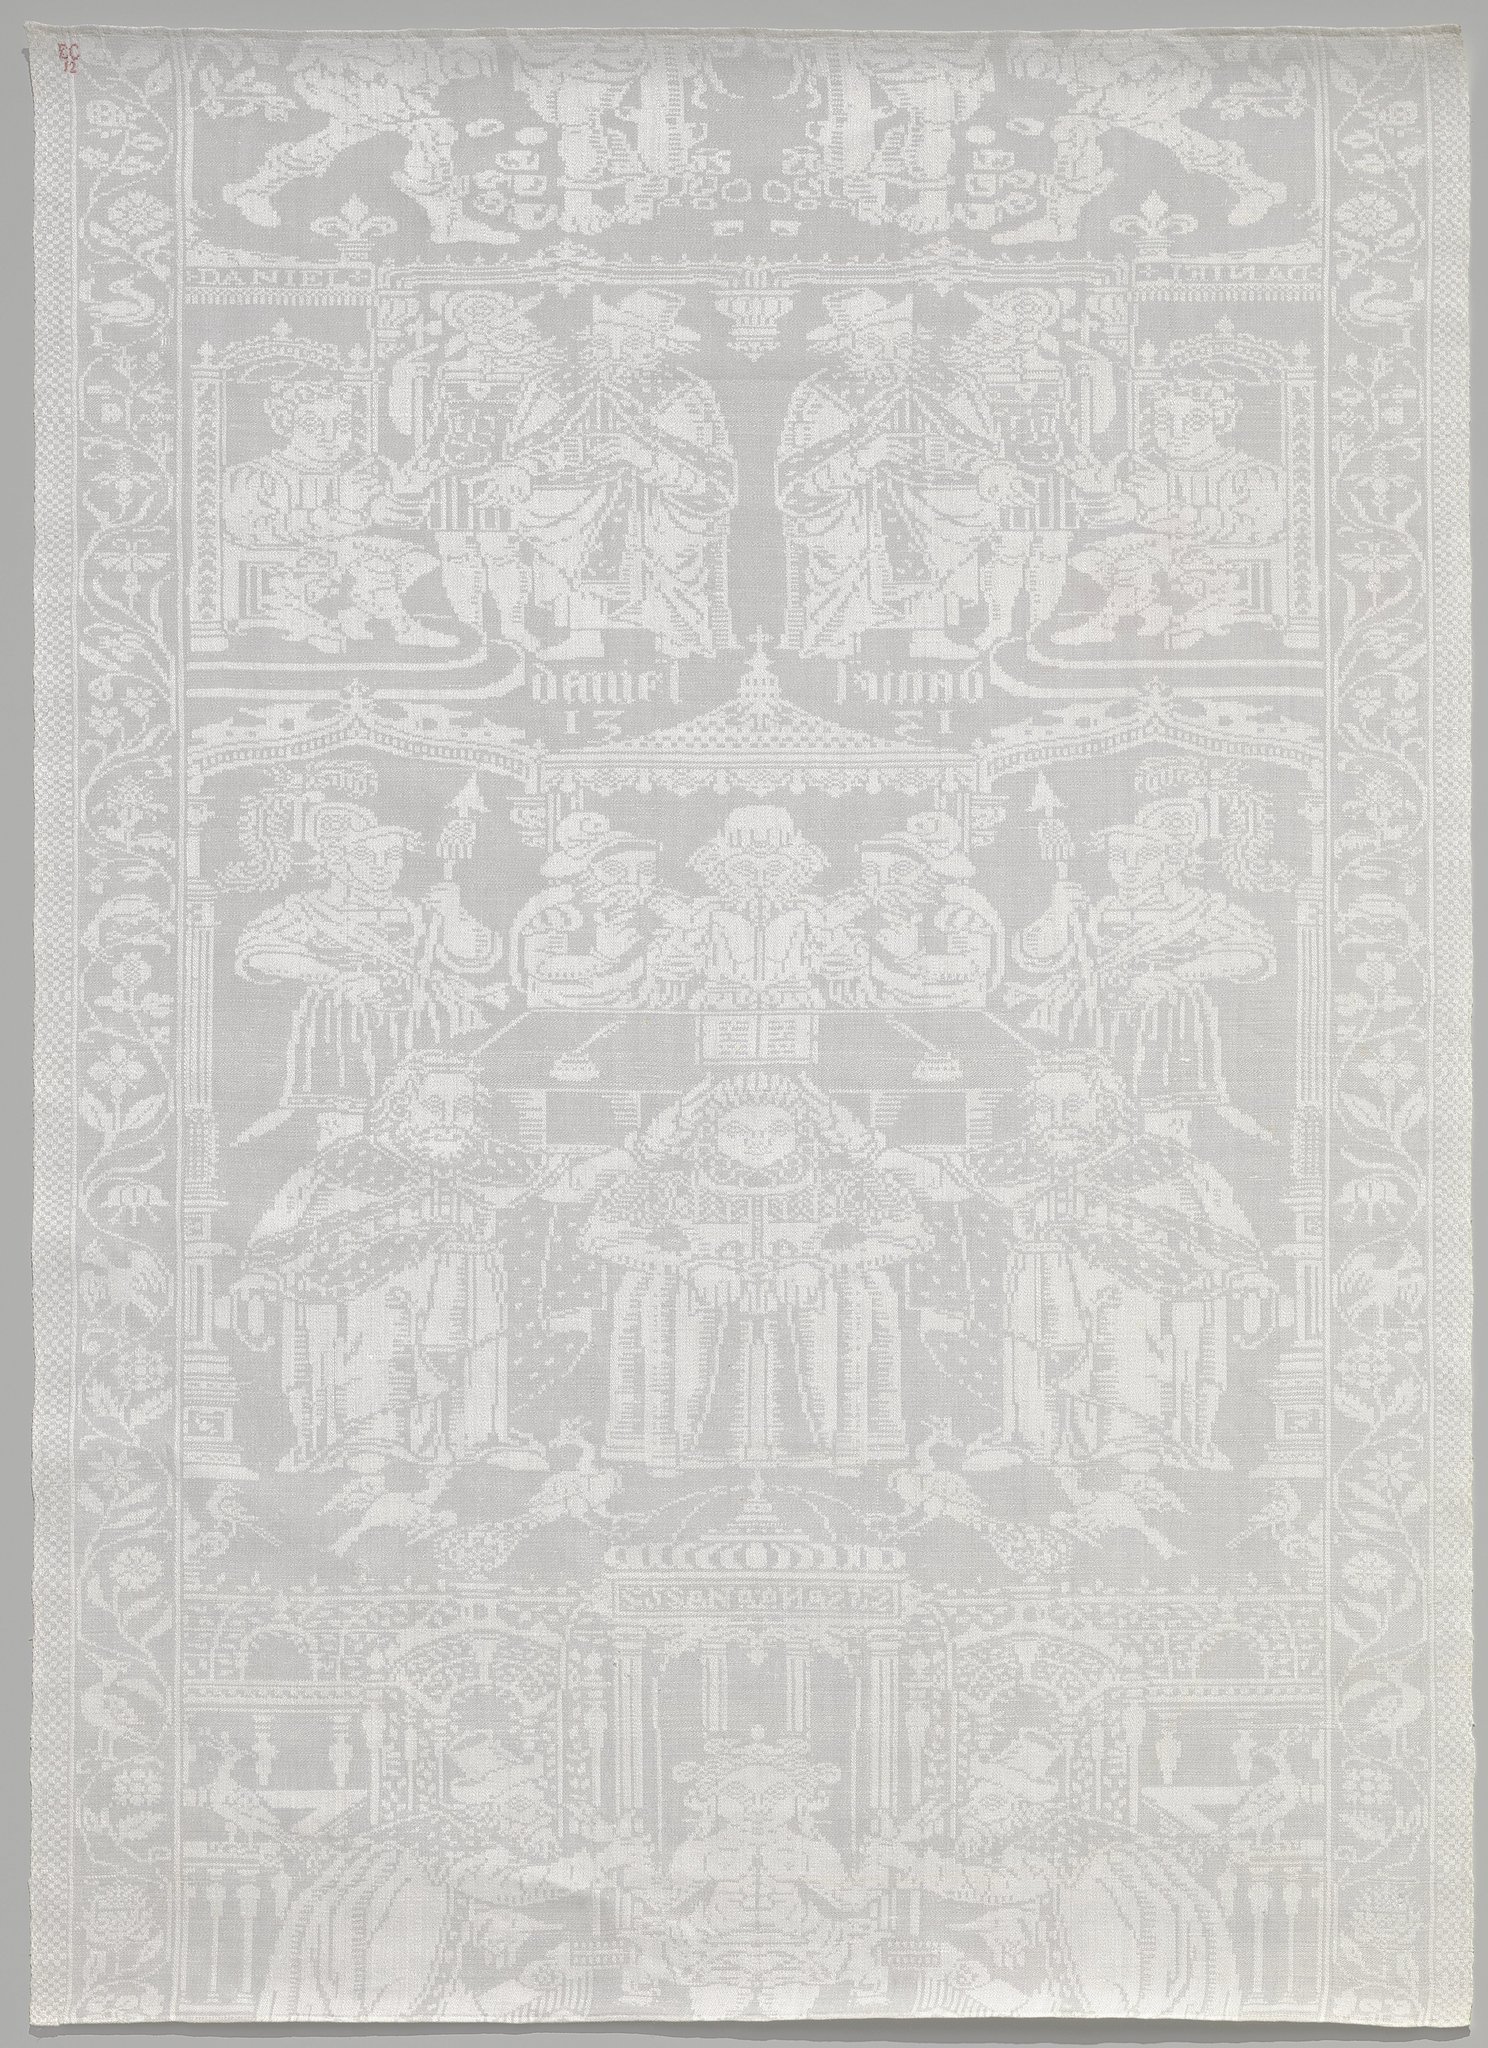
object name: napkin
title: Servet met de geschiedenis van Susanna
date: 1600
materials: linen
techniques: damask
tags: the story of susanna and the elders (in which the youth daniel intervenes on behalf of susanna) (daniel 13)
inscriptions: mark: ‘EC 12’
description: Servet van linnendamast met de geschiedenis van Susanna. Middenveld: het symmetrisch verdubbelde patroon vertoont van onder naar boven drie taferelen: 1 Susanna in het Bad (Gehalveerd). 2 Valse Getuigenis der Oudsten. Voor een rechtbank, in het midden, staat Susanna met onbedekt hoofd, een plooikraag om de hals, pofmouwen, en een brede vertugadin-rok. De twee oudsten, de een het spiegelbeeld van de ander, leggen een hand op haar hoofd. 3 Daniël's Oordeel. Op een rechterstoel met opschrift DANIEL is een man gezeten, die afzonderlijk aan de oudsten gevraagd had onder welke boom zij Susanna gezien hadden. Staande randen: enkelvoudige rank met bloemen en vogels.